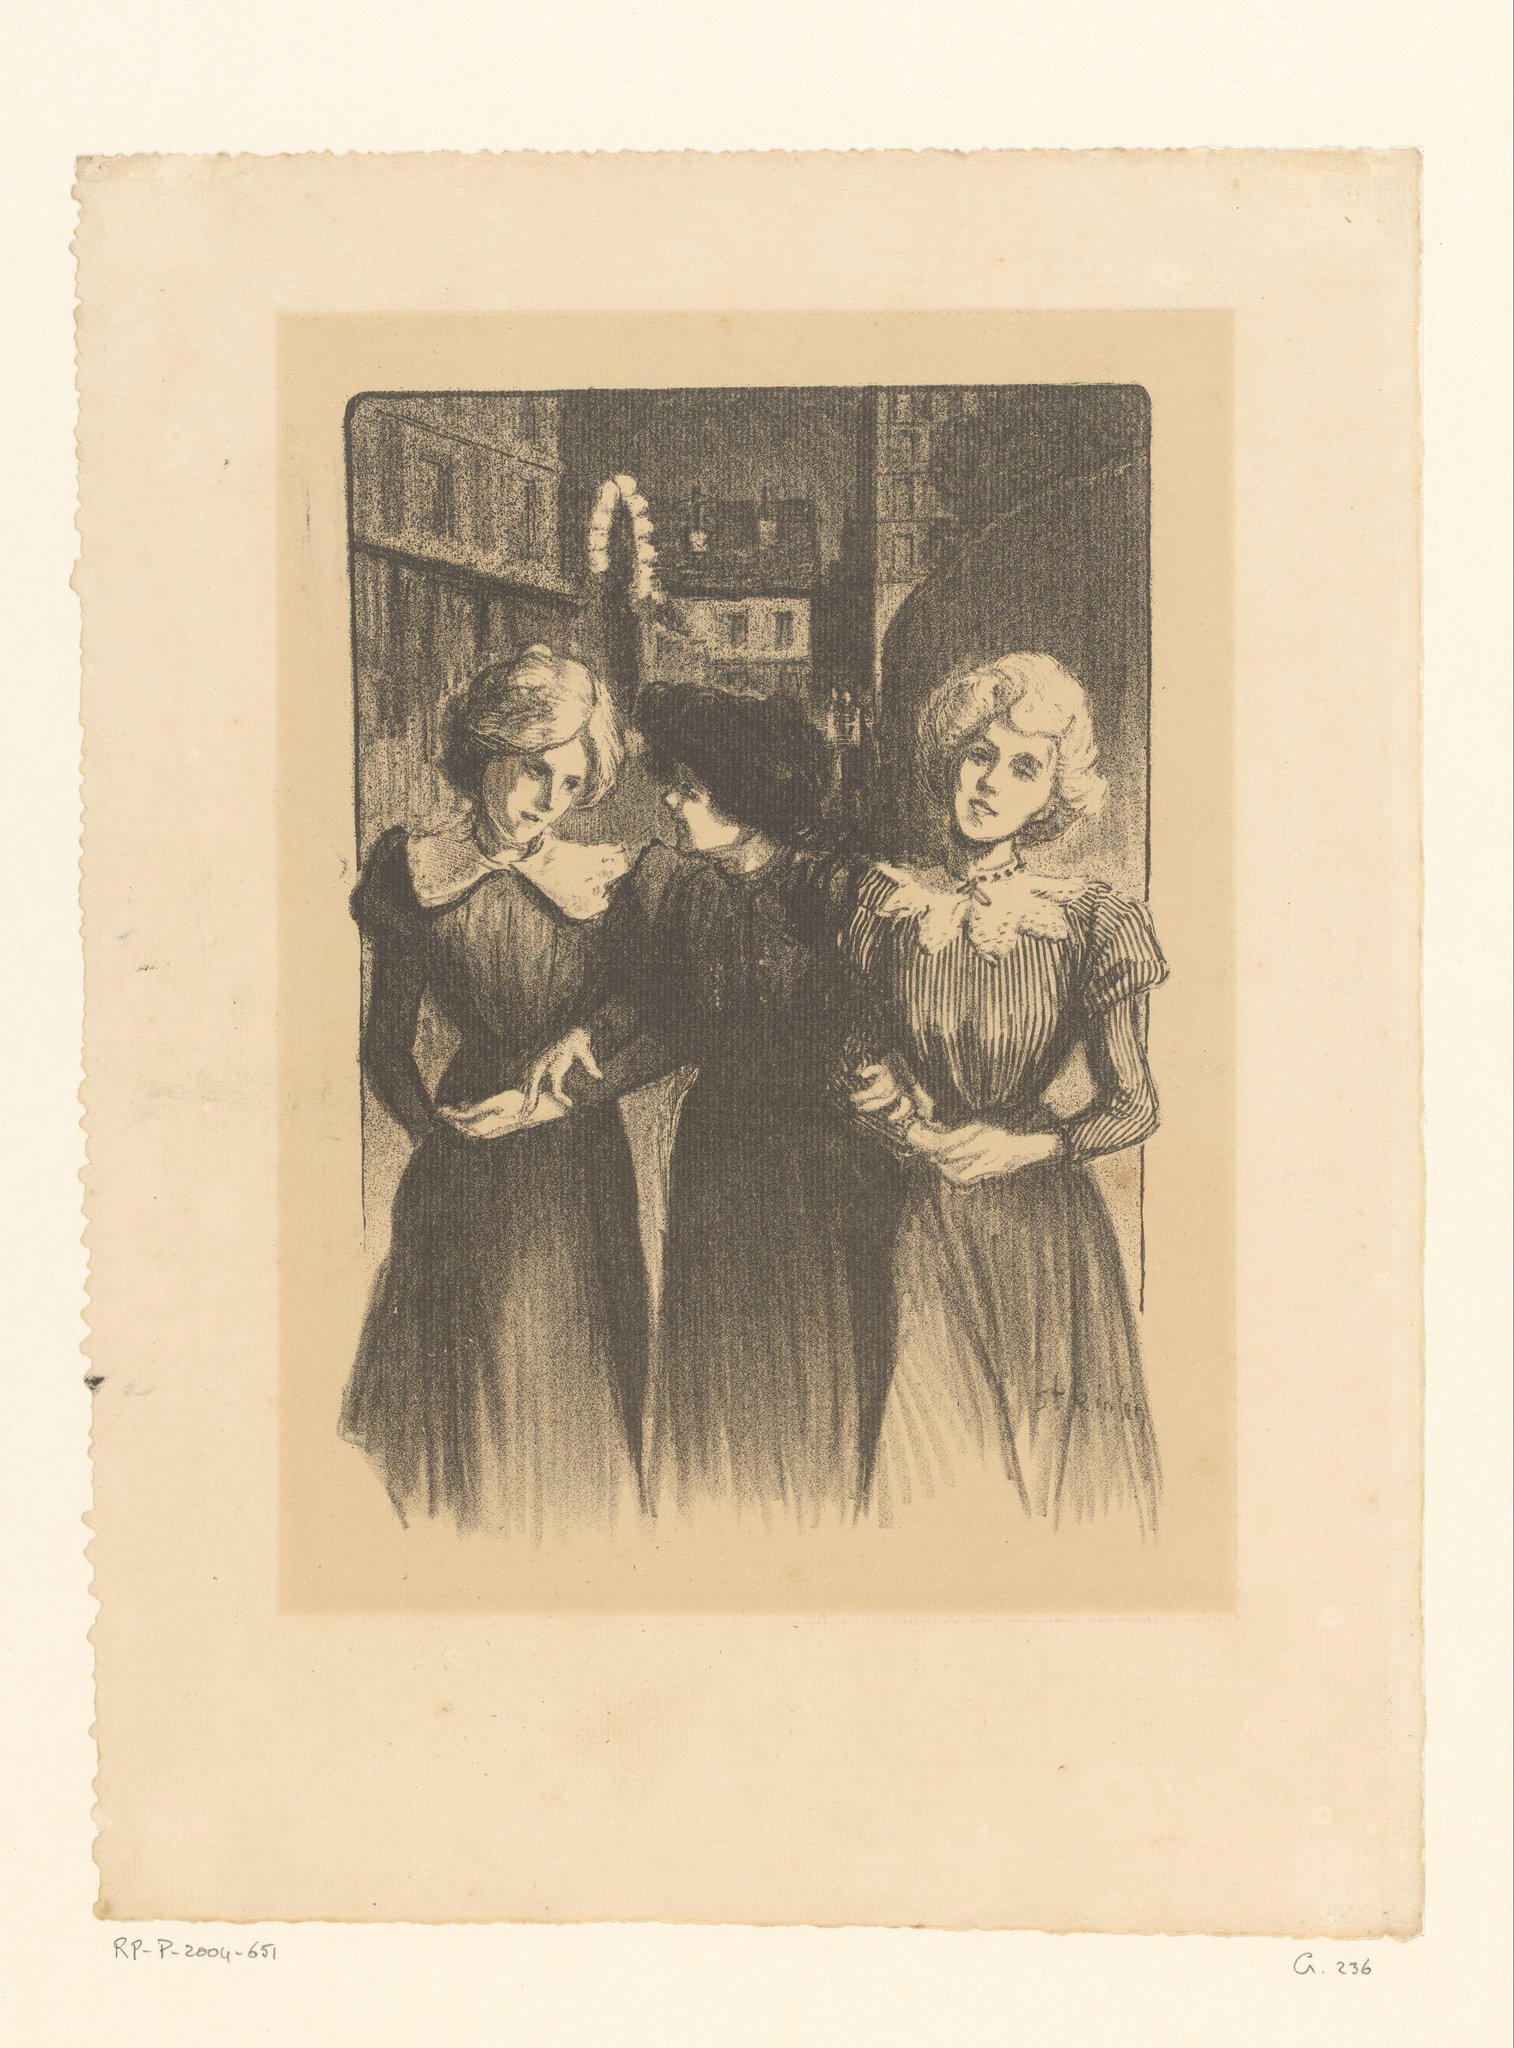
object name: print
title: L'heure du déjeuner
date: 1899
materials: paper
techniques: tone lithography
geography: paris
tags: walking, adult woman (+ two persons)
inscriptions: collector's mark: Lugt 2228